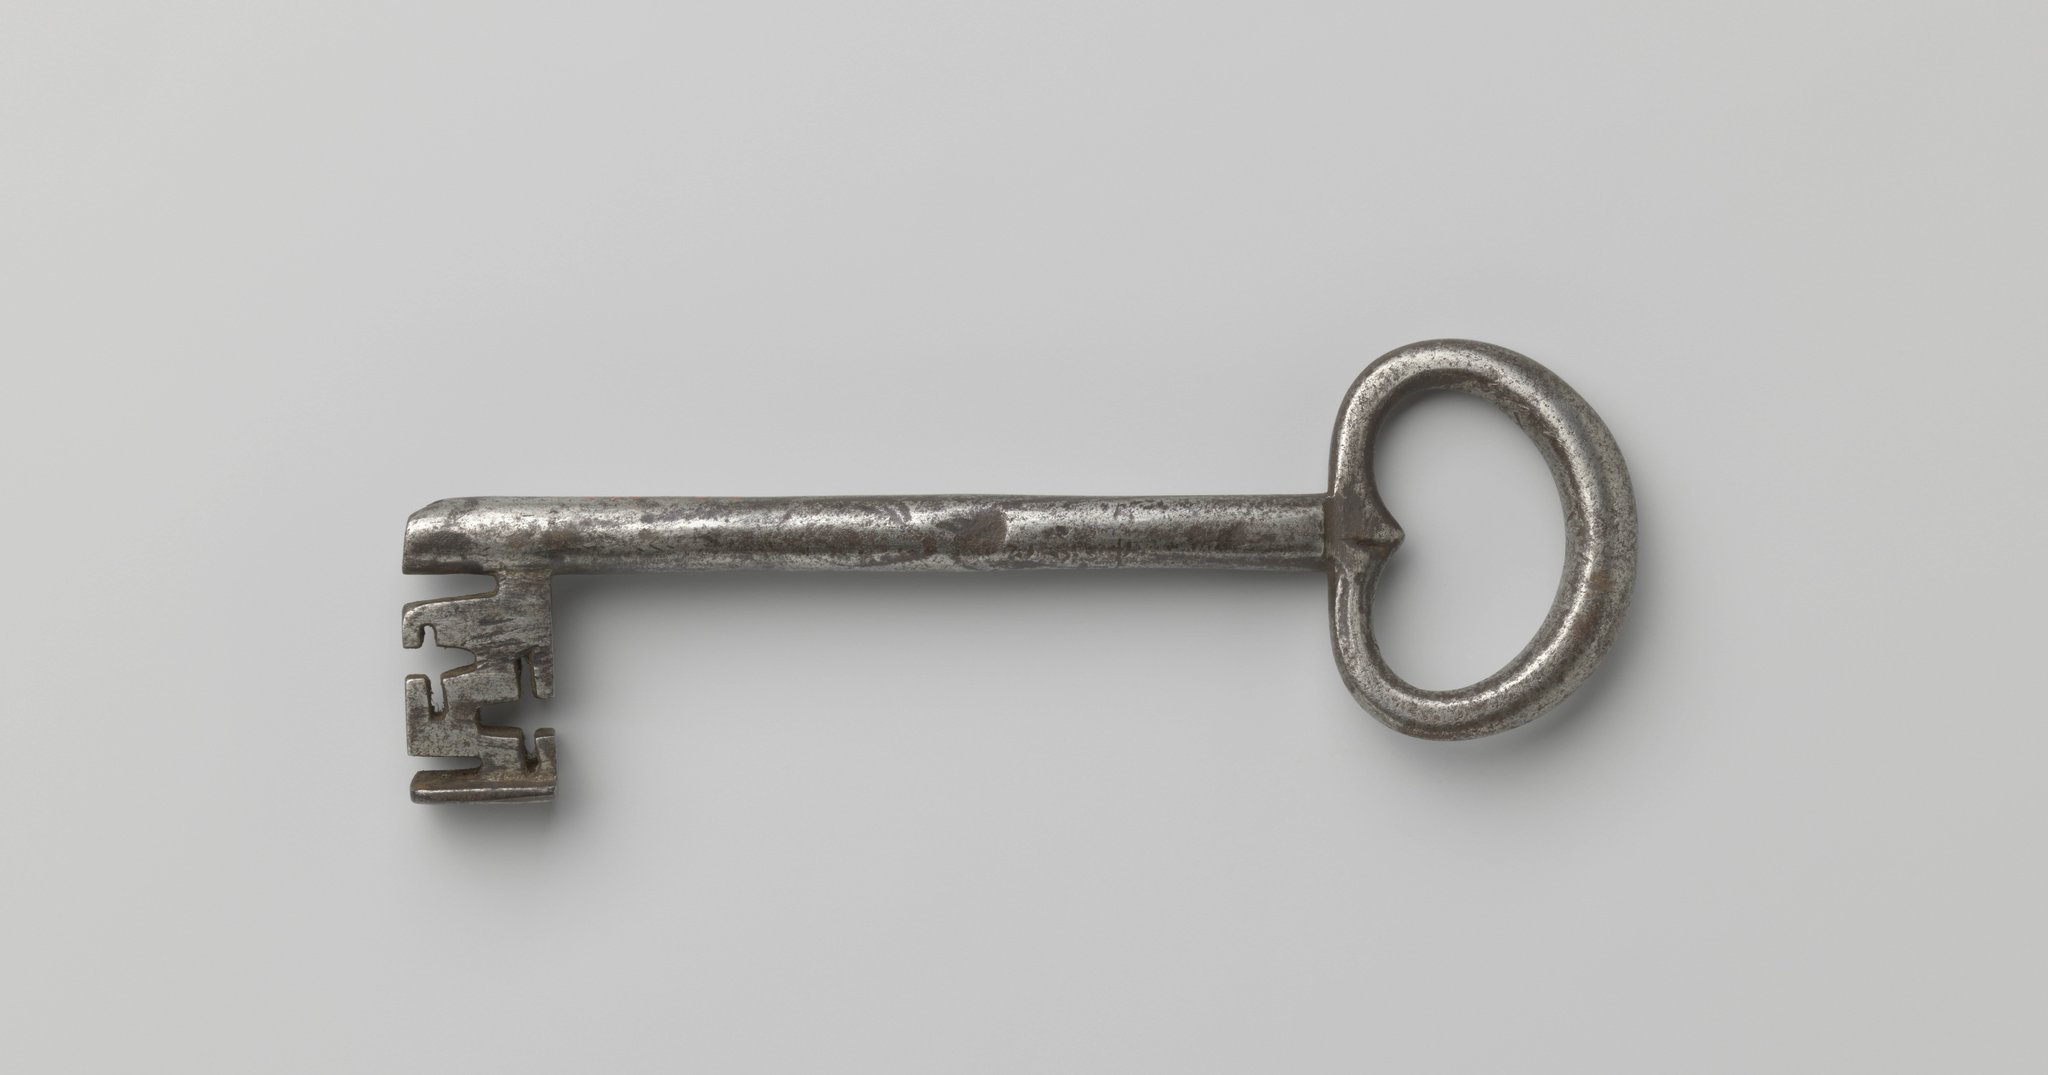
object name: key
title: Kastsleutel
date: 1600-1699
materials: iron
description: Kastsleutel met boonvormig oog en lange, gedeeltelijk geboorde schacht, die onderaan beschadigd is.